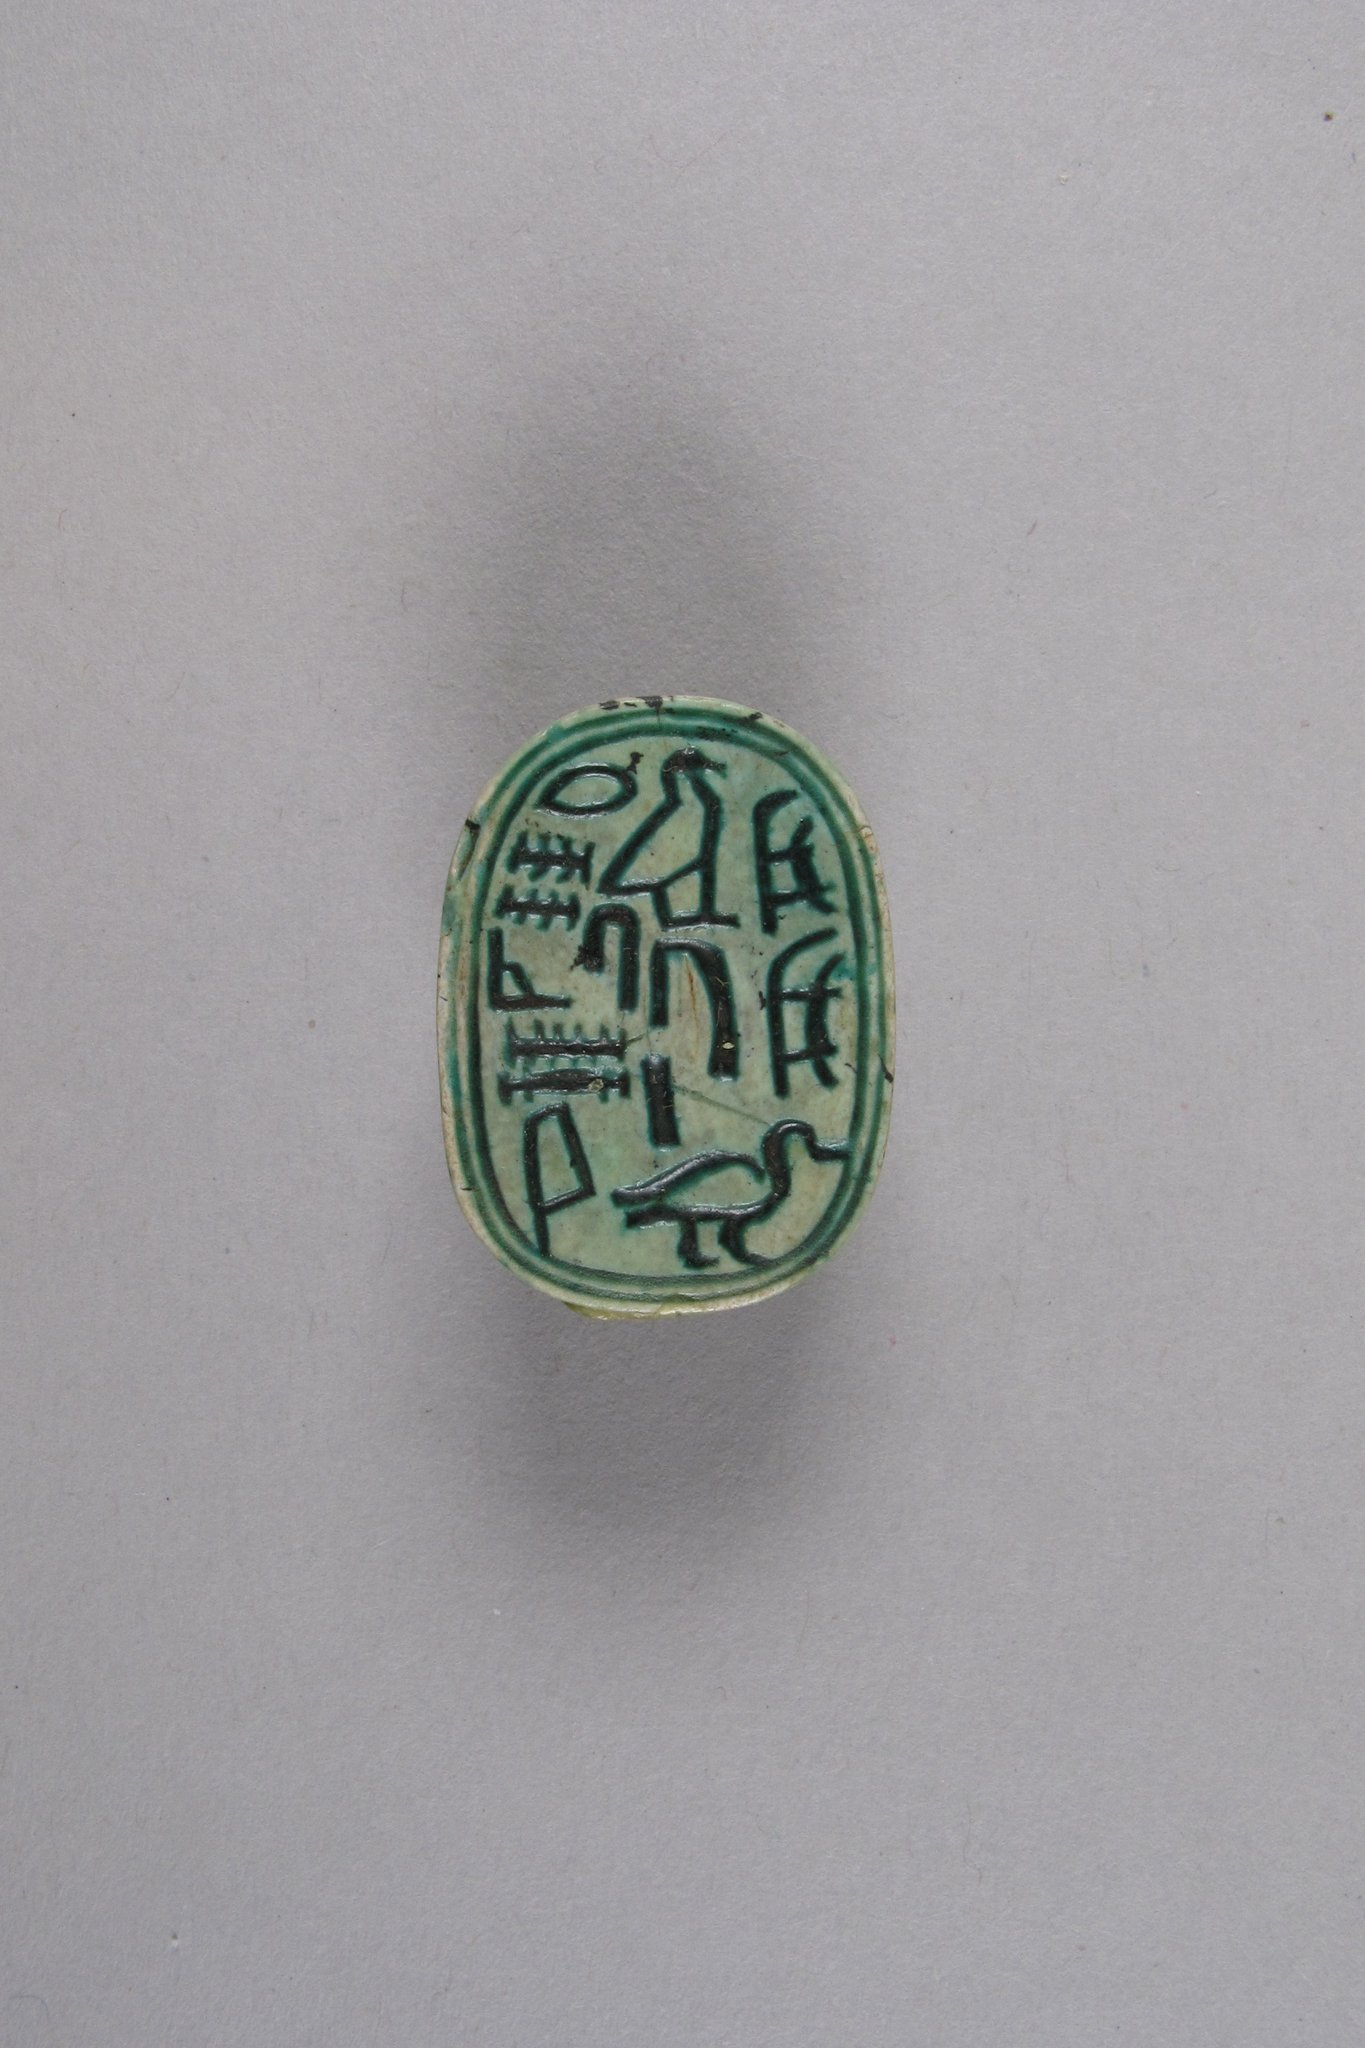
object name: scarab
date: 1802-1575 BCE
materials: stone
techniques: glazing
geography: egypt